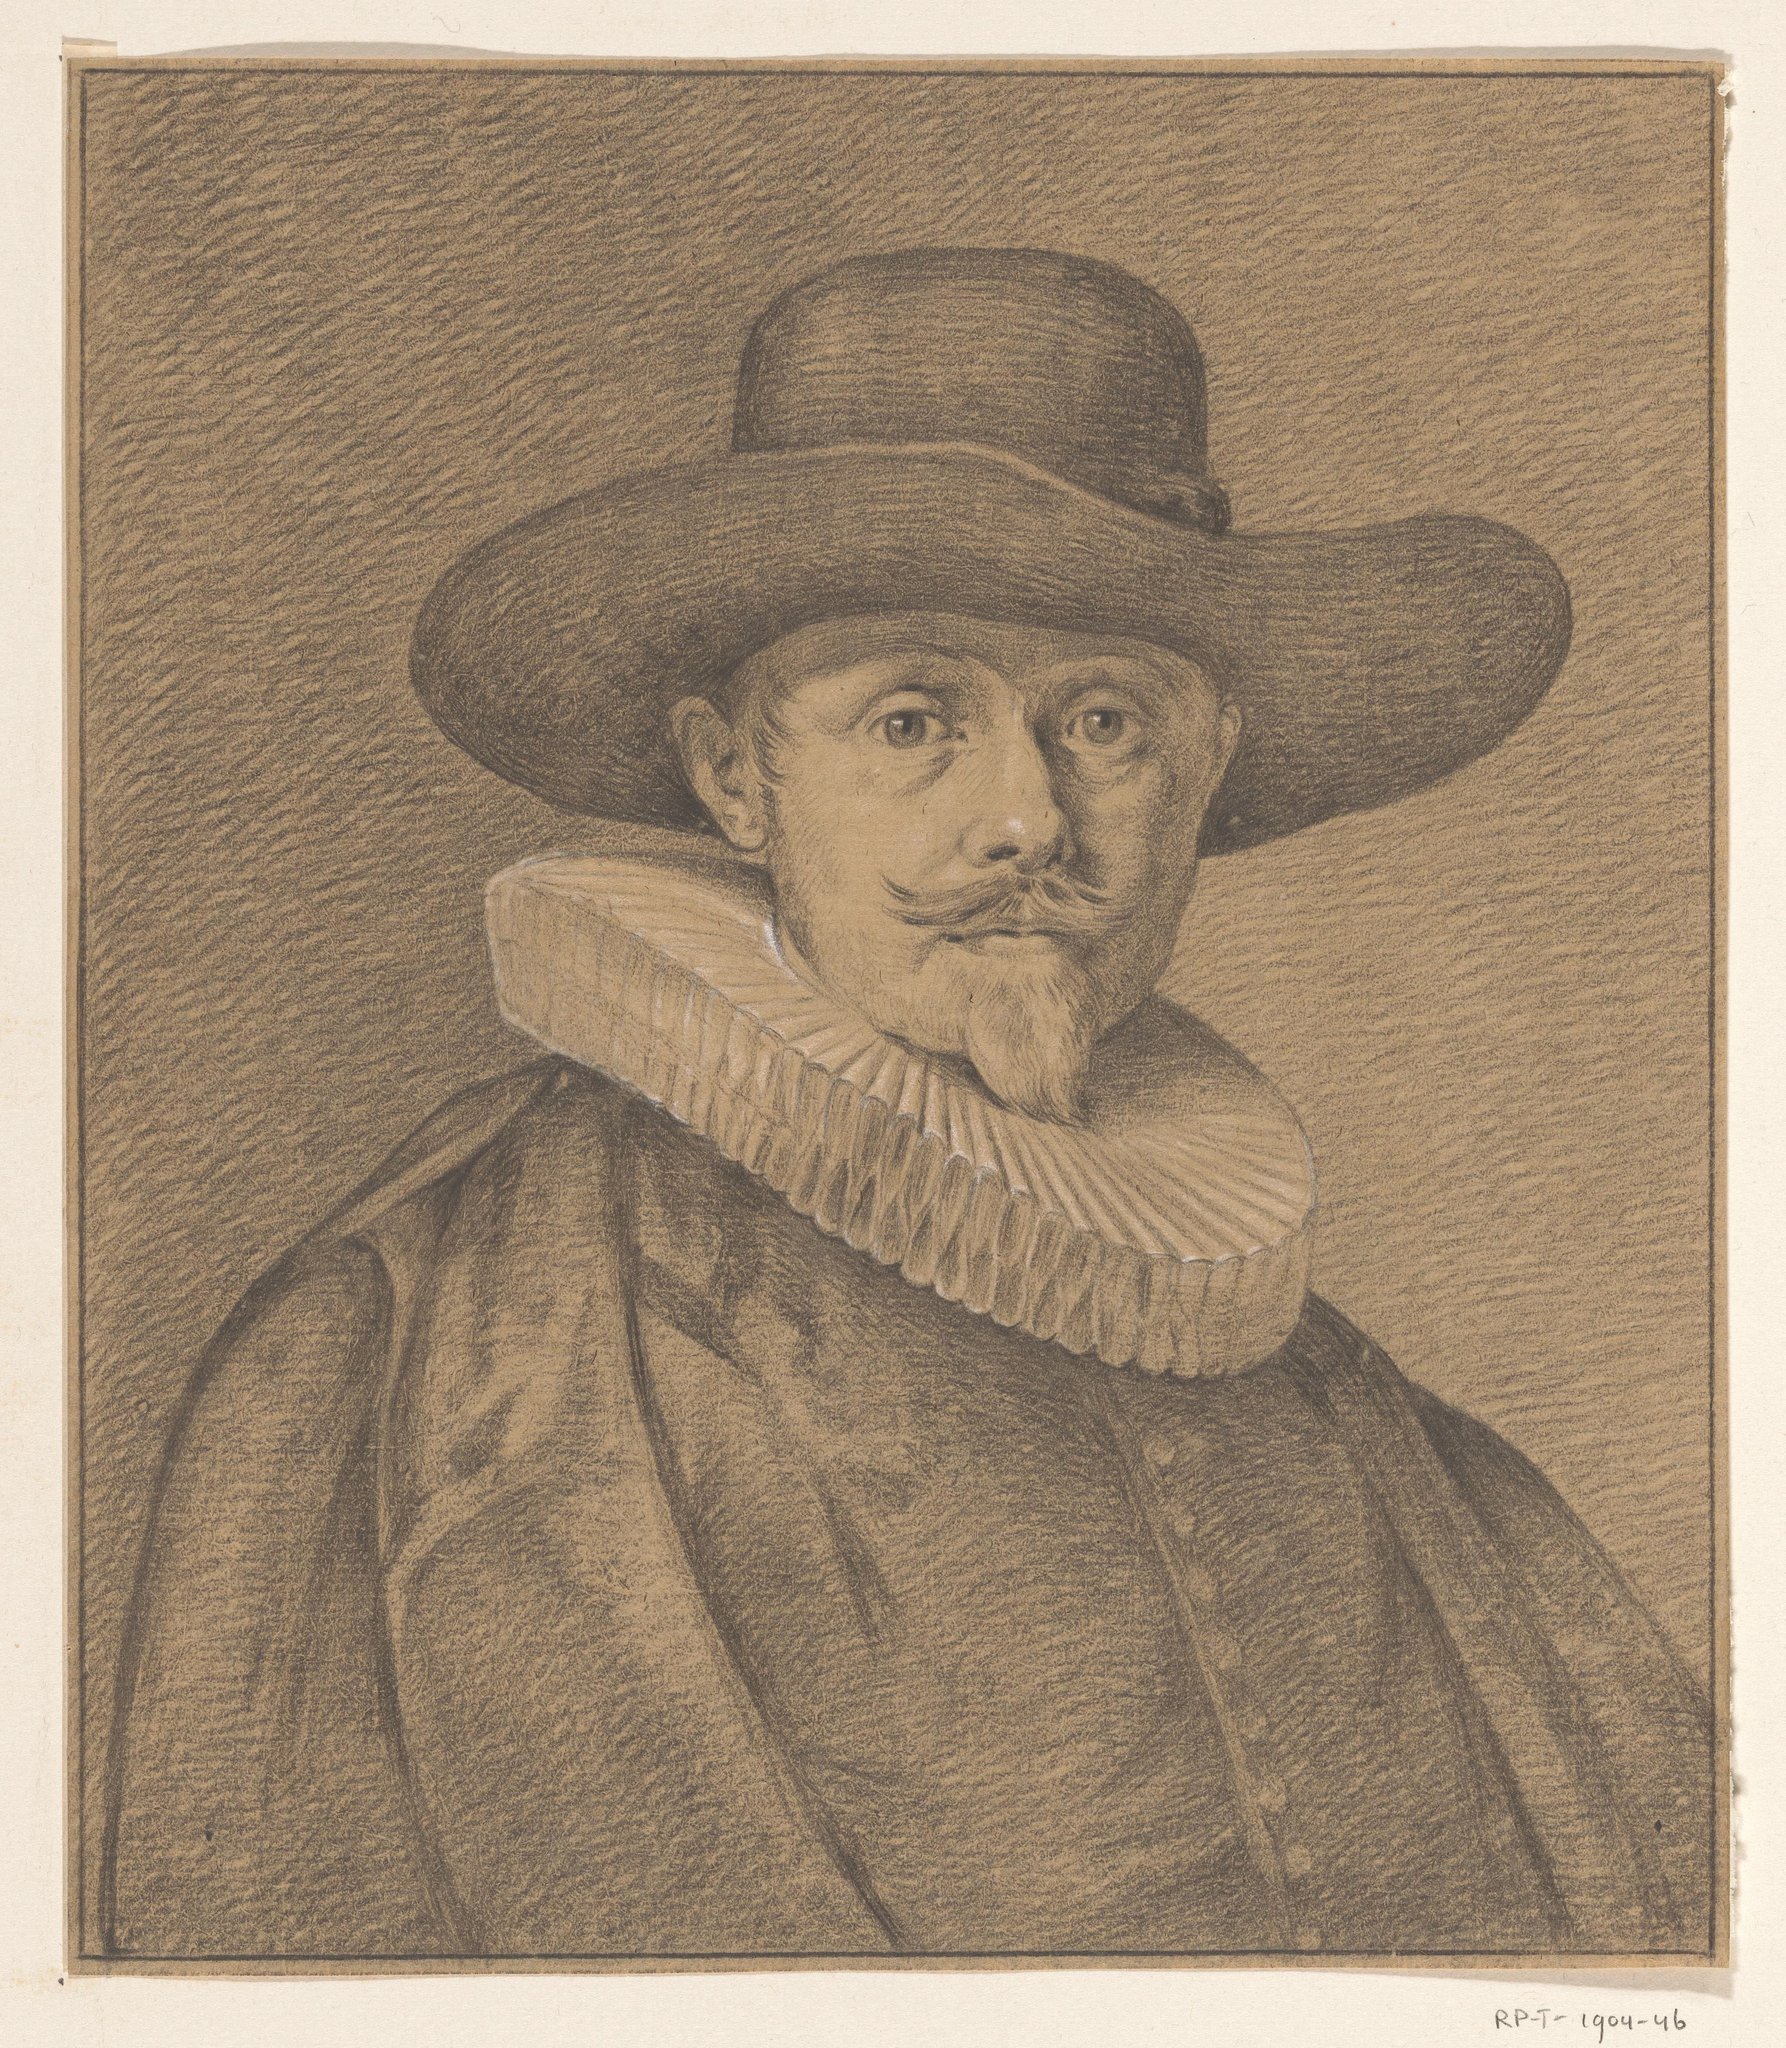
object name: drawing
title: Portret van Aelbert Cuyper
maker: jean bernard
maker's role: draughtsman, print maker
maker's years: 1765-1833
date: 1775-1833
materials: chalk, paper, pencil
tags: historical persons